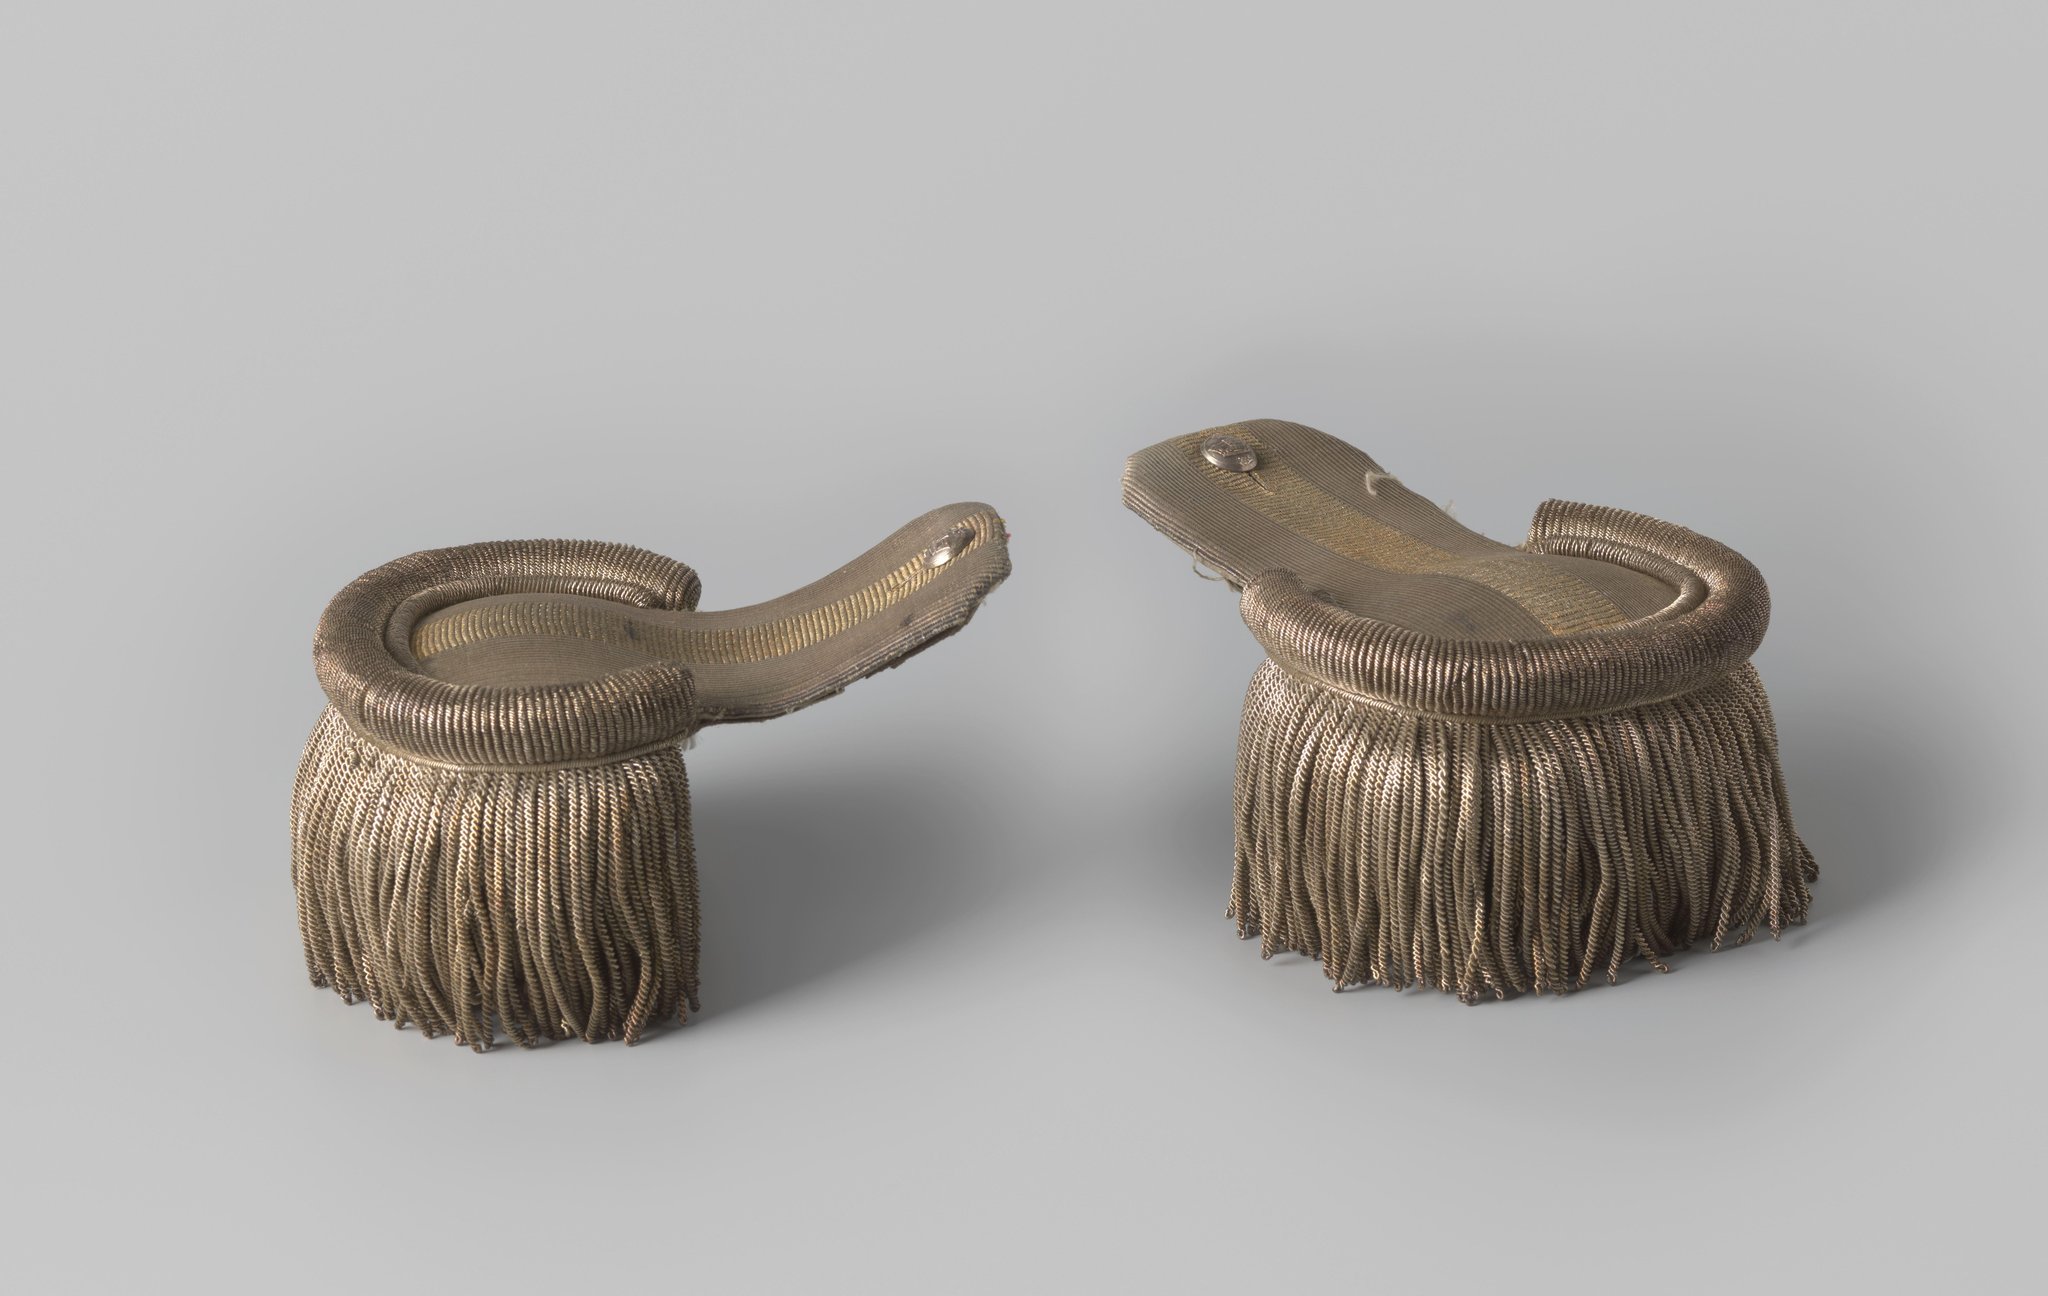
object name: uniform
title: Epaulet van zilverdraad, met één gouden streep en met torsades (dunne franjes), onderdeel van een schutterij-uniform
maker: becker (kleermaker)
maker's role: kleermaker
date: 1809-1829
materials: gold thread, thread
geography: amsterdam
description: Epaulet van zilverdraad, met één gouden streep en met torsades (dunne franjes), onderdeel van een schutterij-uniform.